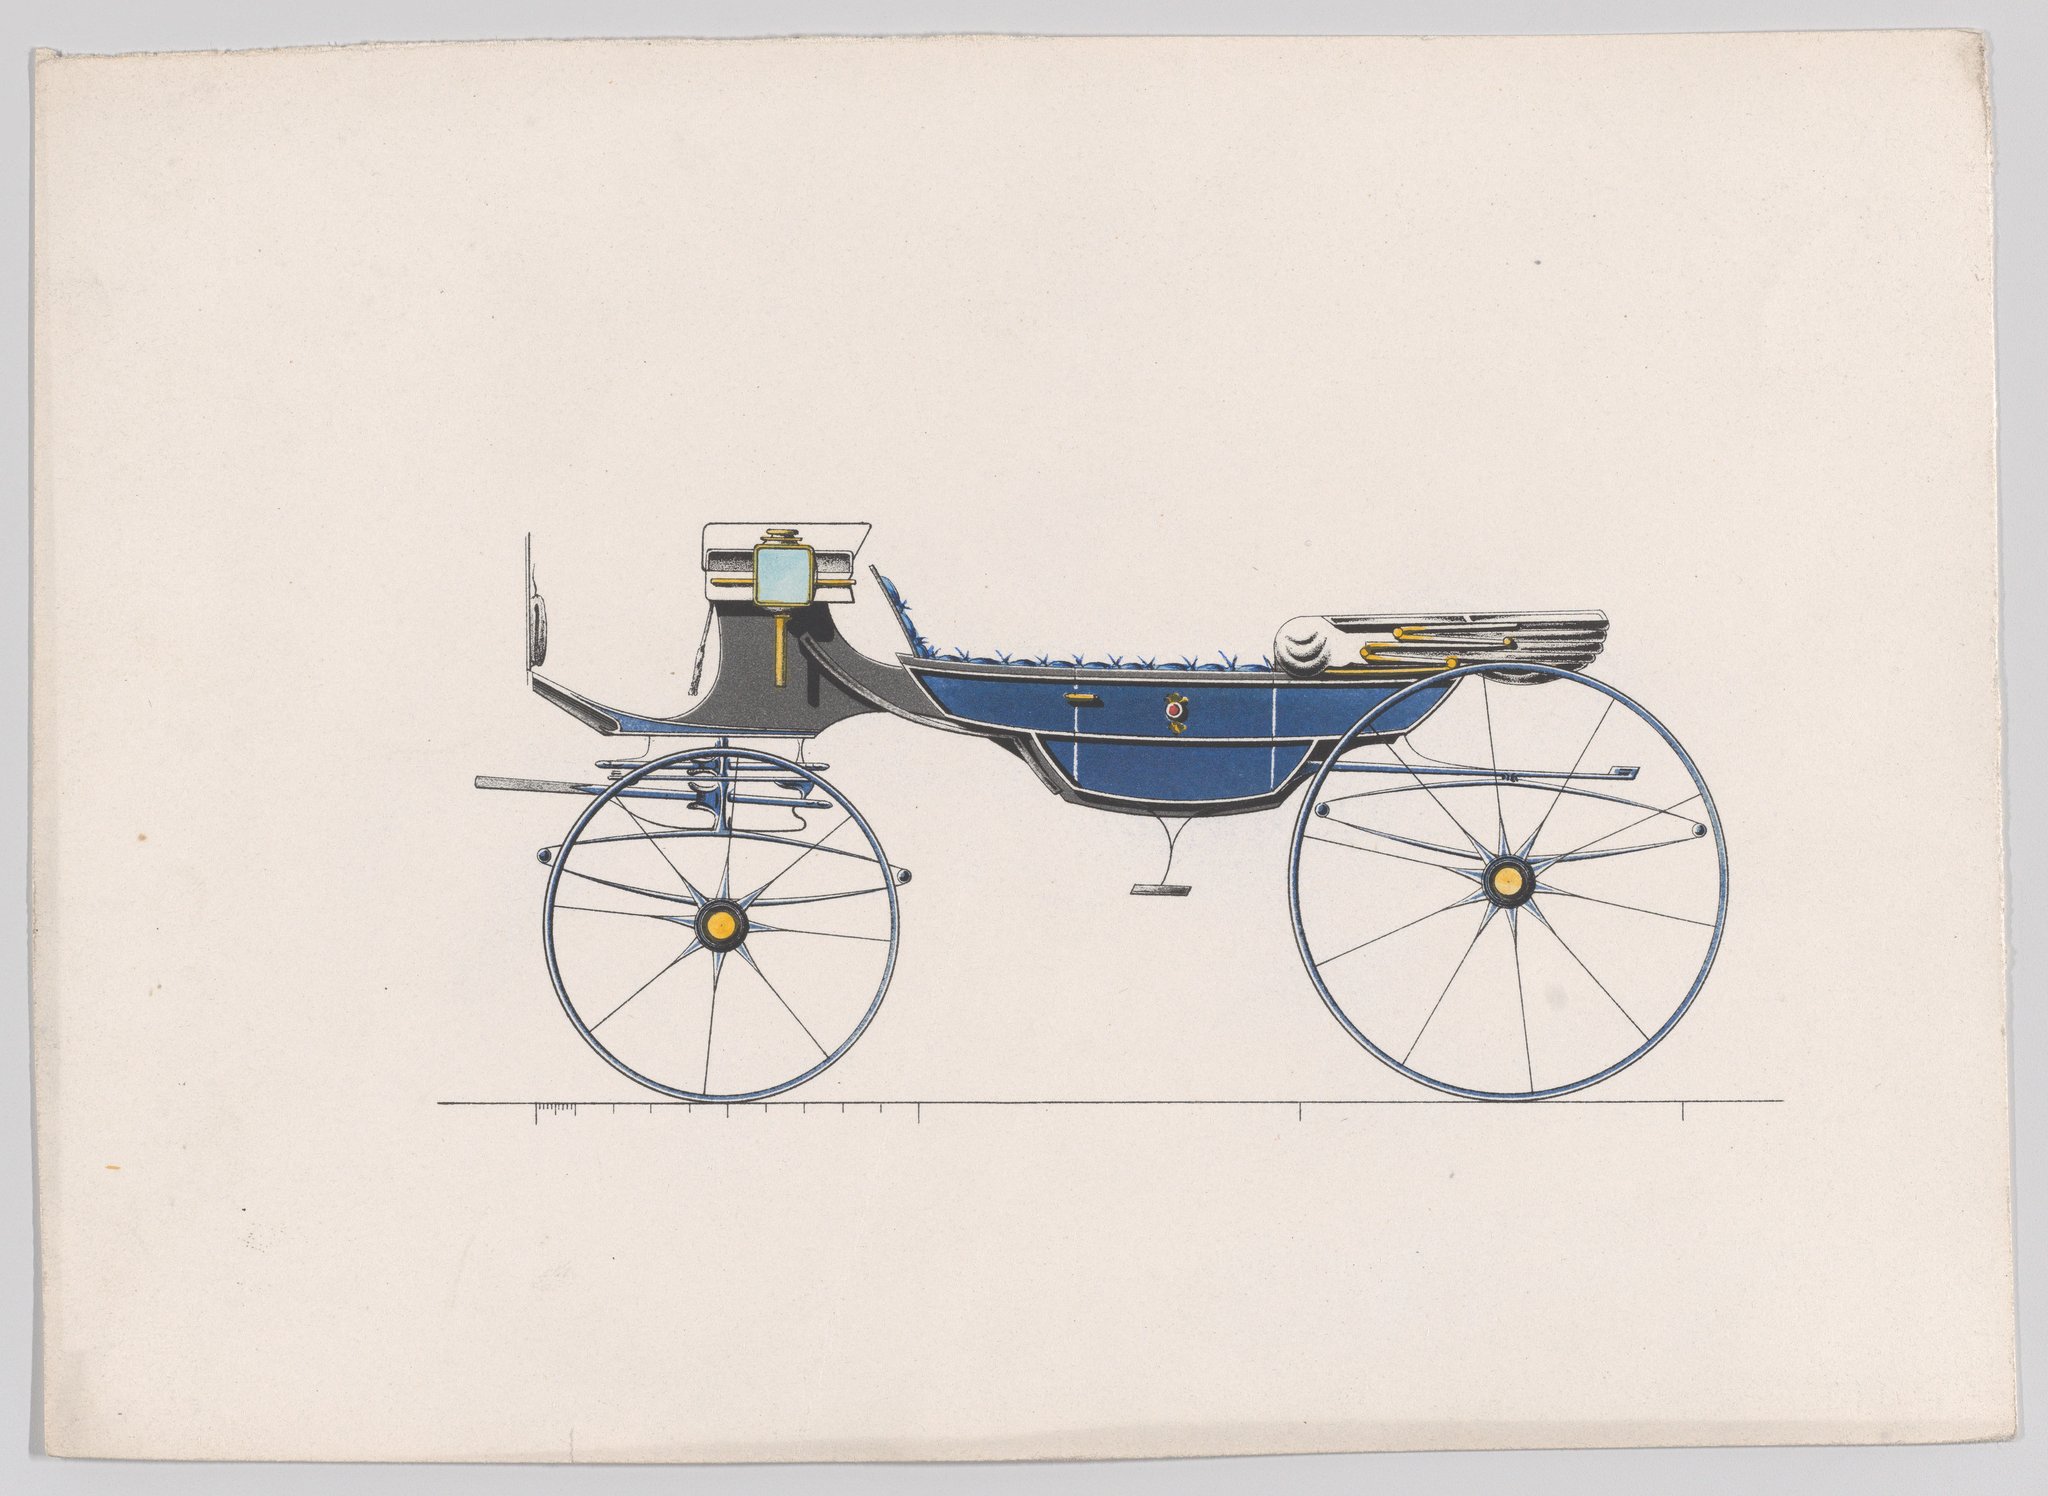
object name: print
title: Design for Vis-A-Vis Carriage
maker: anonymous, french, 19th century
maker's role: artist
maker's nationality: french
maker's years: 1800-1900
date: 1880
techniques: hand coloring, lithograph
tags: carriages